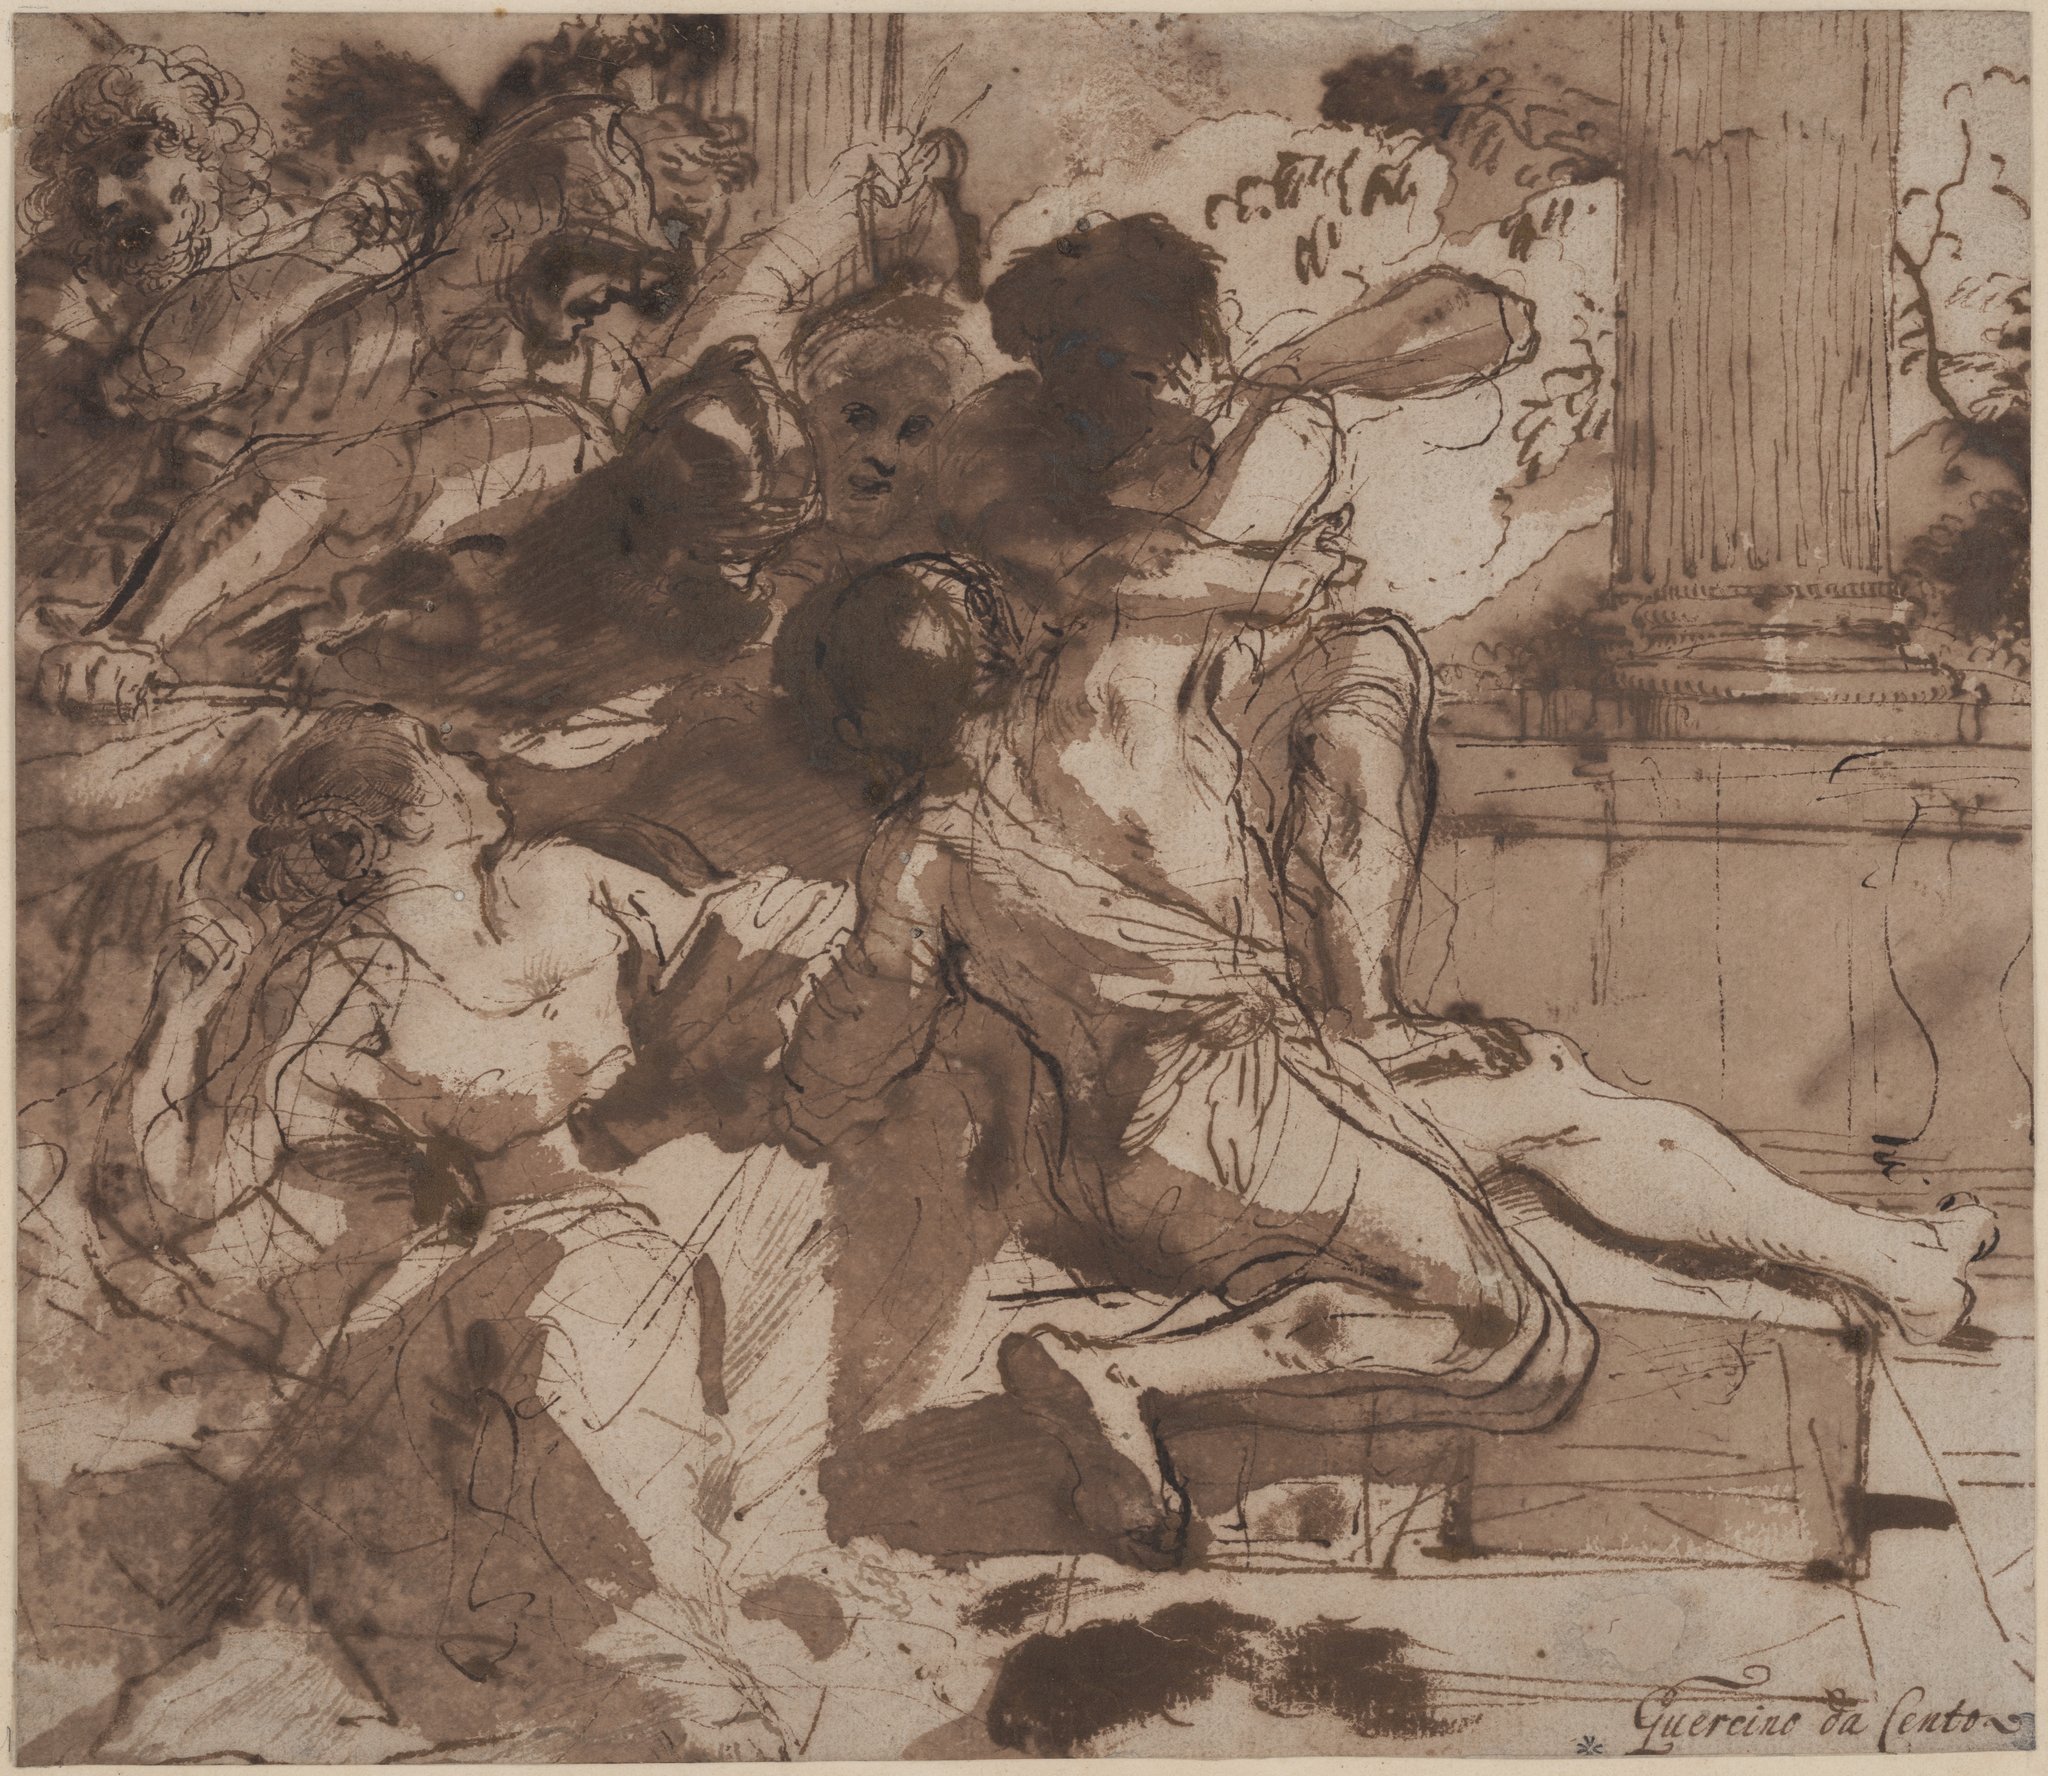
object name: drawing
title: Samson Captured by the Philistines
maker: guercino (giovanni francesco barbieri)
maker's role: artist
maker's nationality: italian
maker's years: 1591-1666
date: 1619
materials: ink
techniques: brush, pen, wash